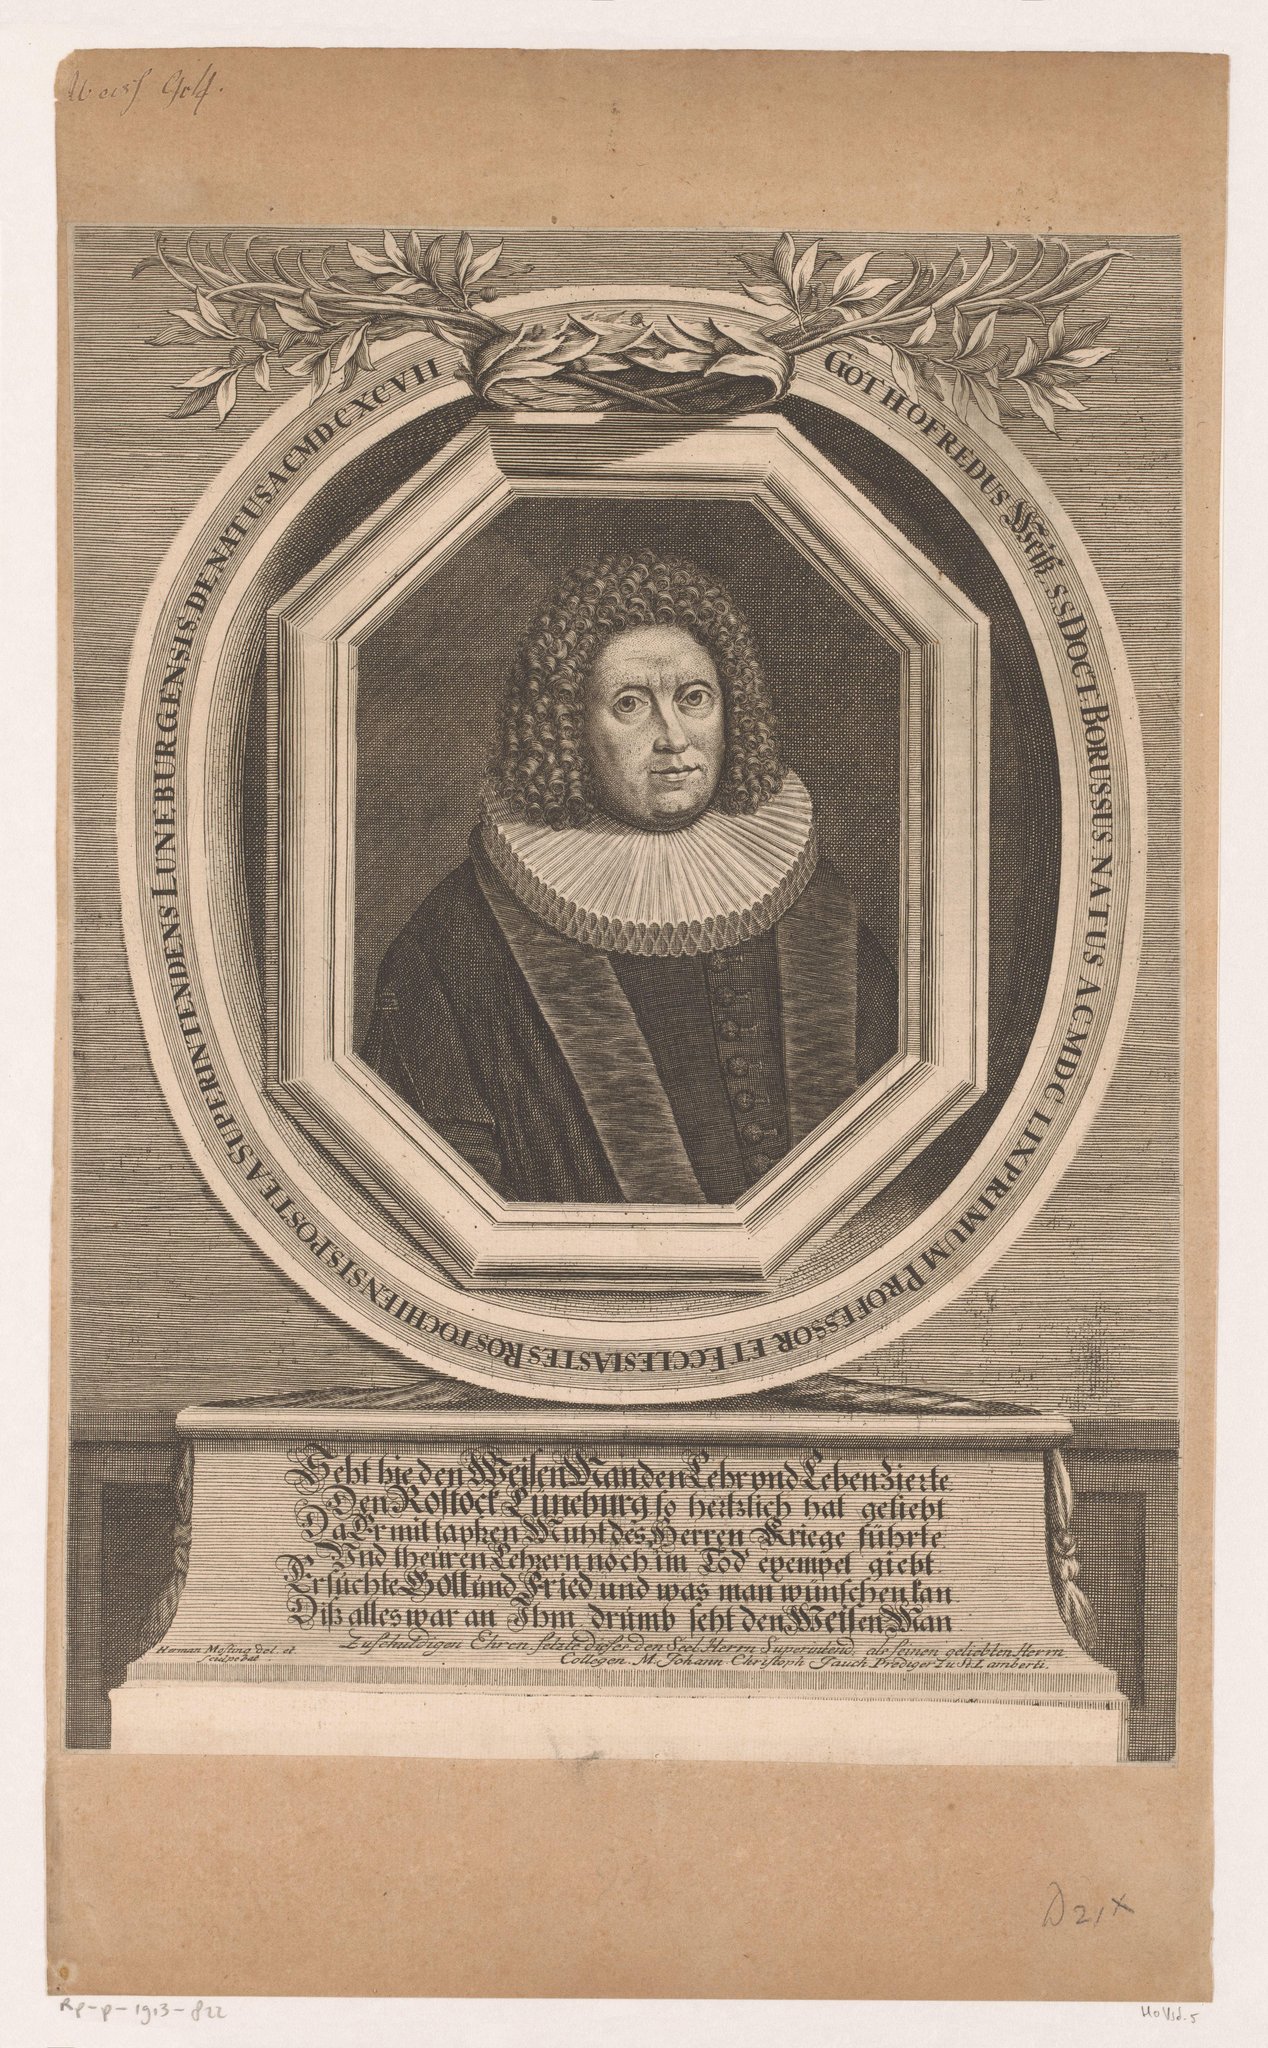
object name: print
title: Portret van Gottfried Weiss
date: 1697-1699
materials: paper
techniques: engraving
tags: theologian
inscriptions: collector's mark: Lugt 2228